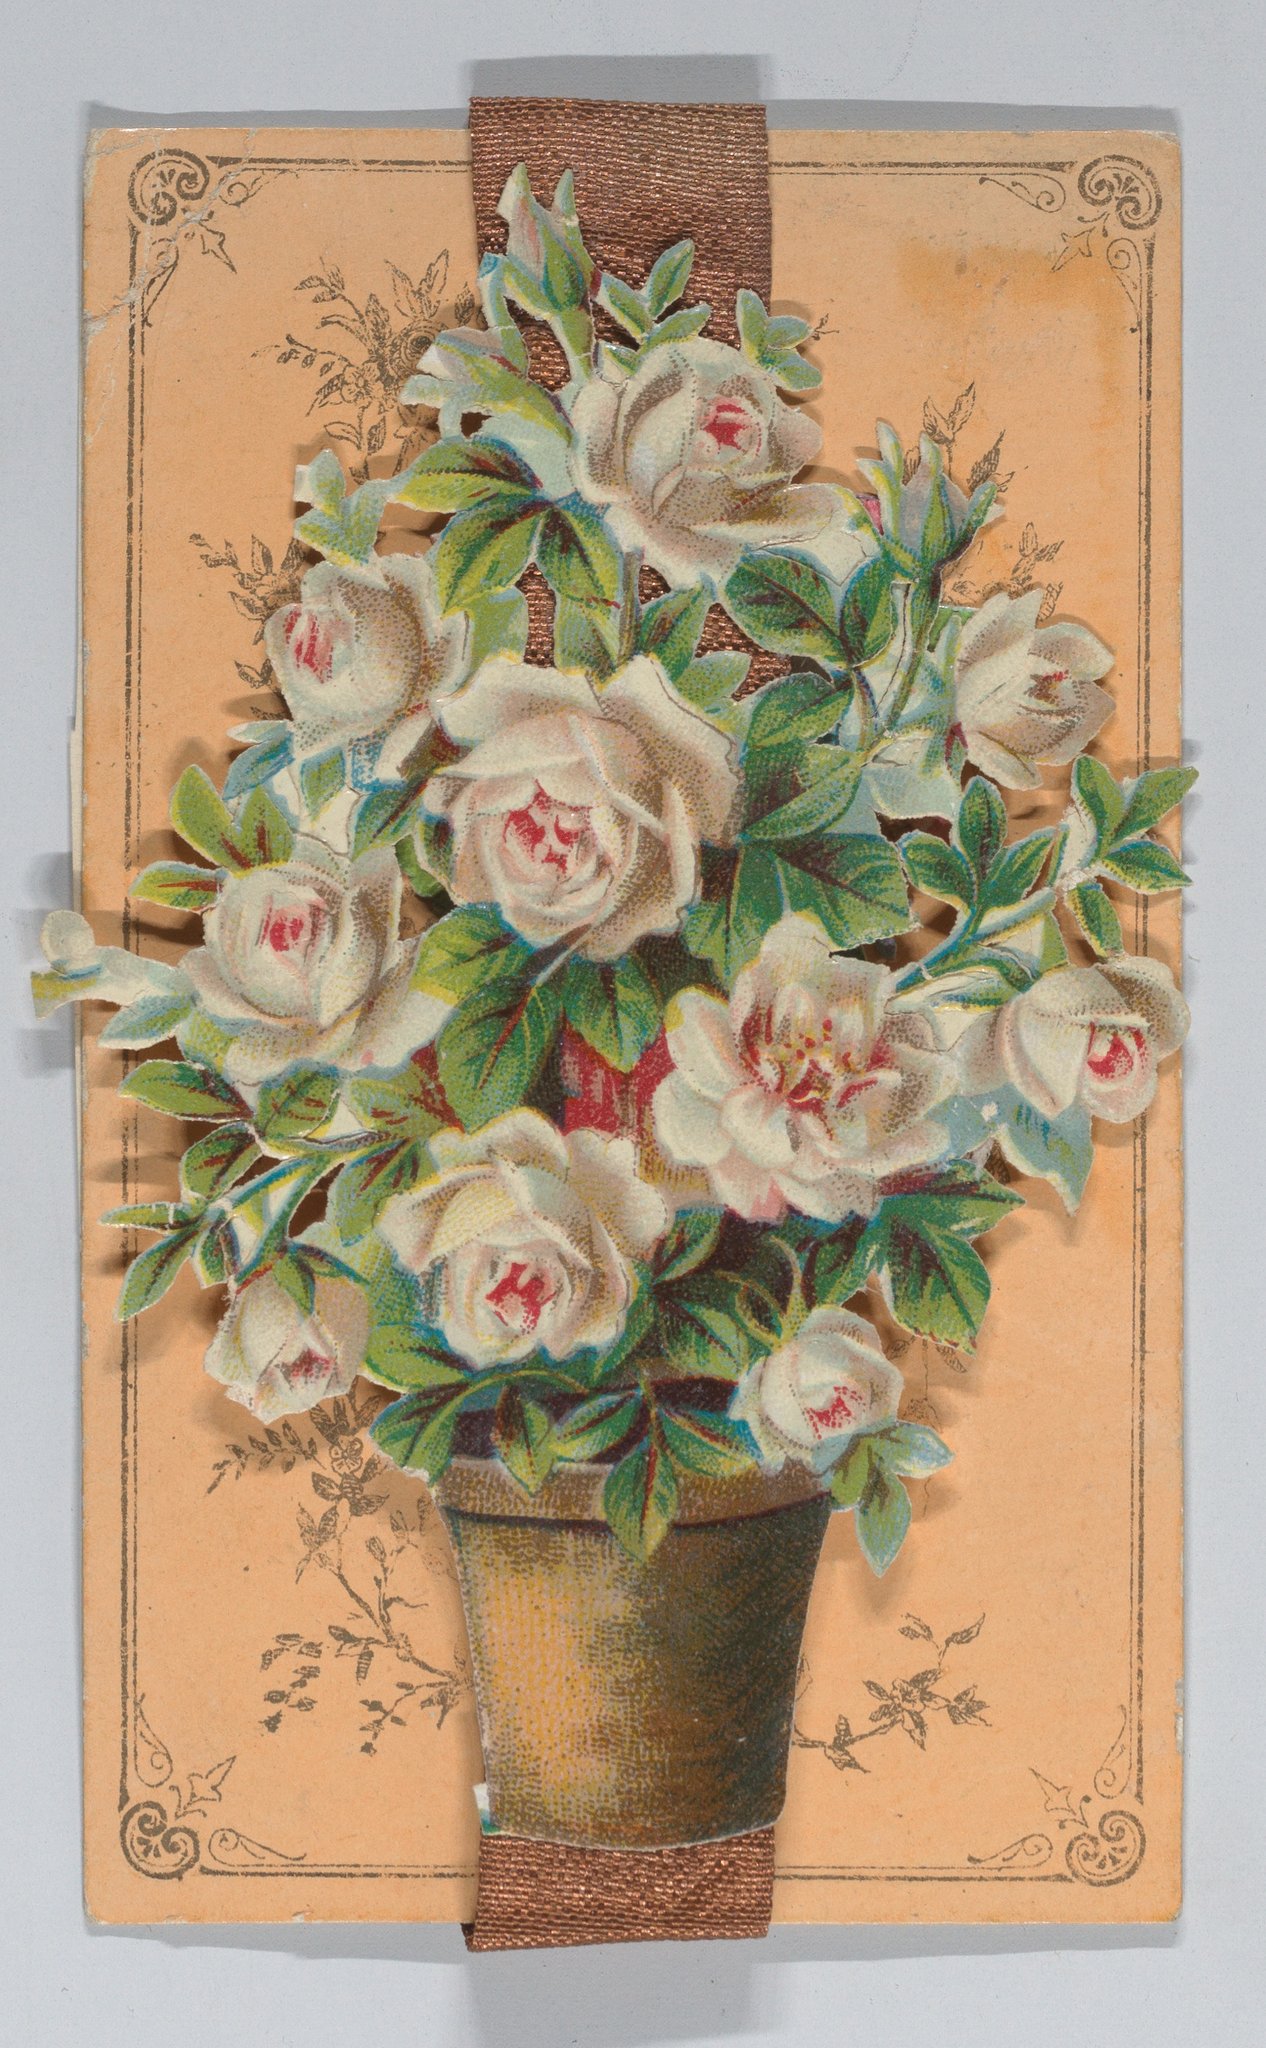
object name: valentine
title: Valentine - Hand assembled with scrap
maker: anonymous, american, 19th century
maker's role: artist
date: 1875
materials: ribbon, silk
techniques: chromolithography, cutting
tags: flowers